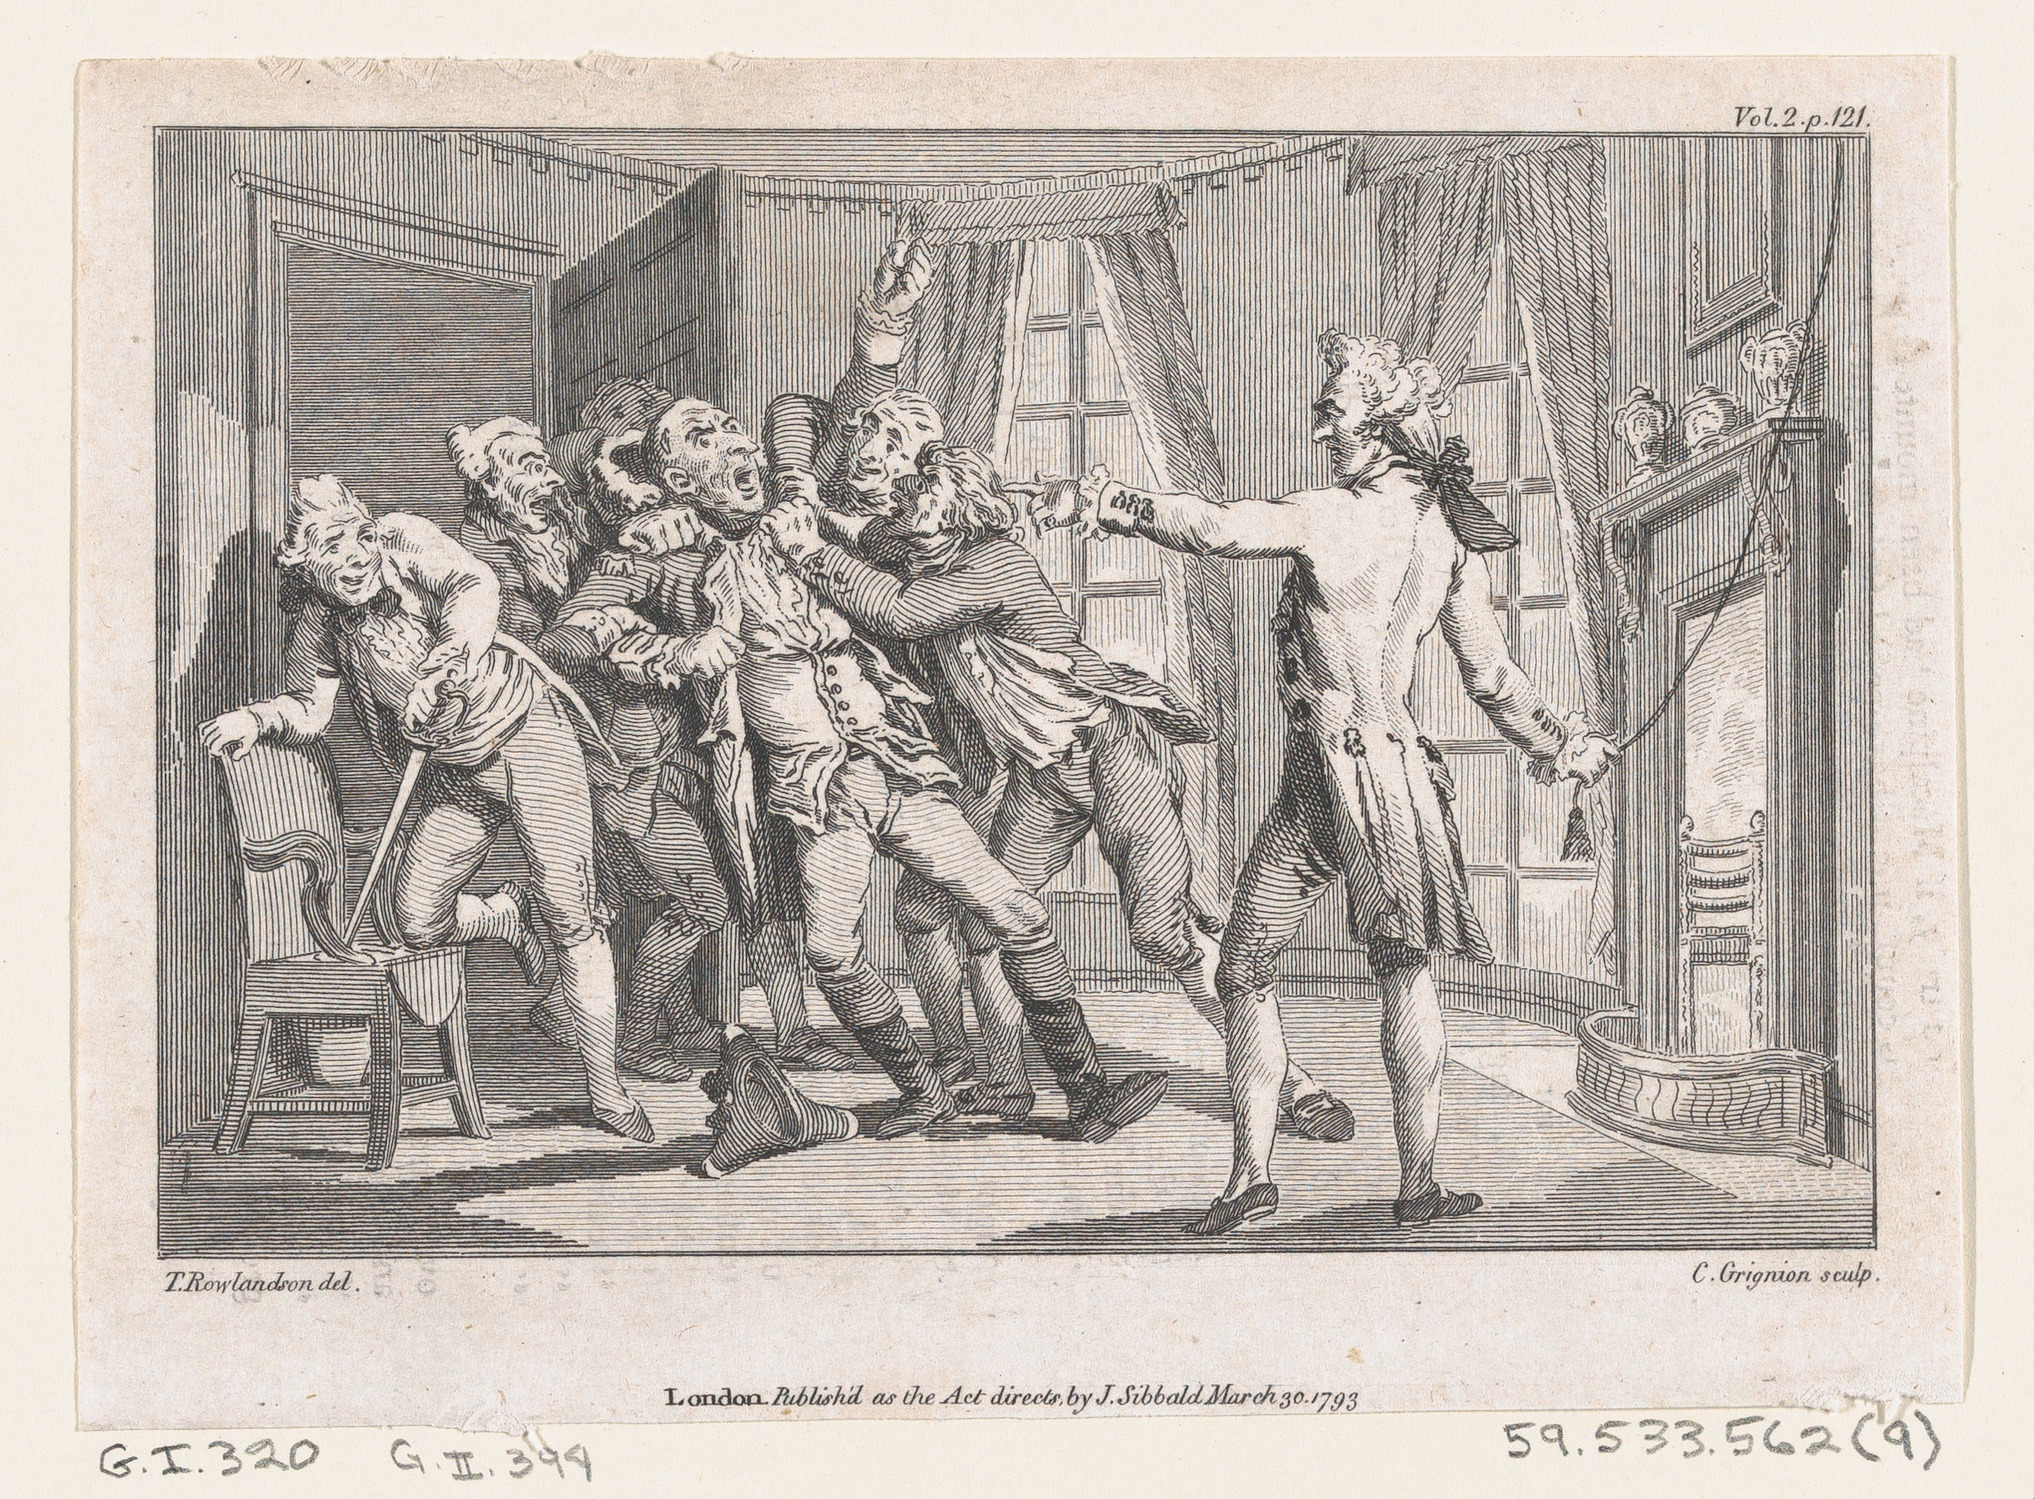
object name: print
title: Lord Oxmington Repelling Lismahago's Challenge to Single Combat, an illustration from Tobias Smollett's "The Expedition of Humphry Clinker" (London, 1793), Vol. 1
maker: charles grignion, i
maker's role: artist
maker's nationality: british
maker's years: 1710-1810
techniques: engraving, etching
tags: satire,men